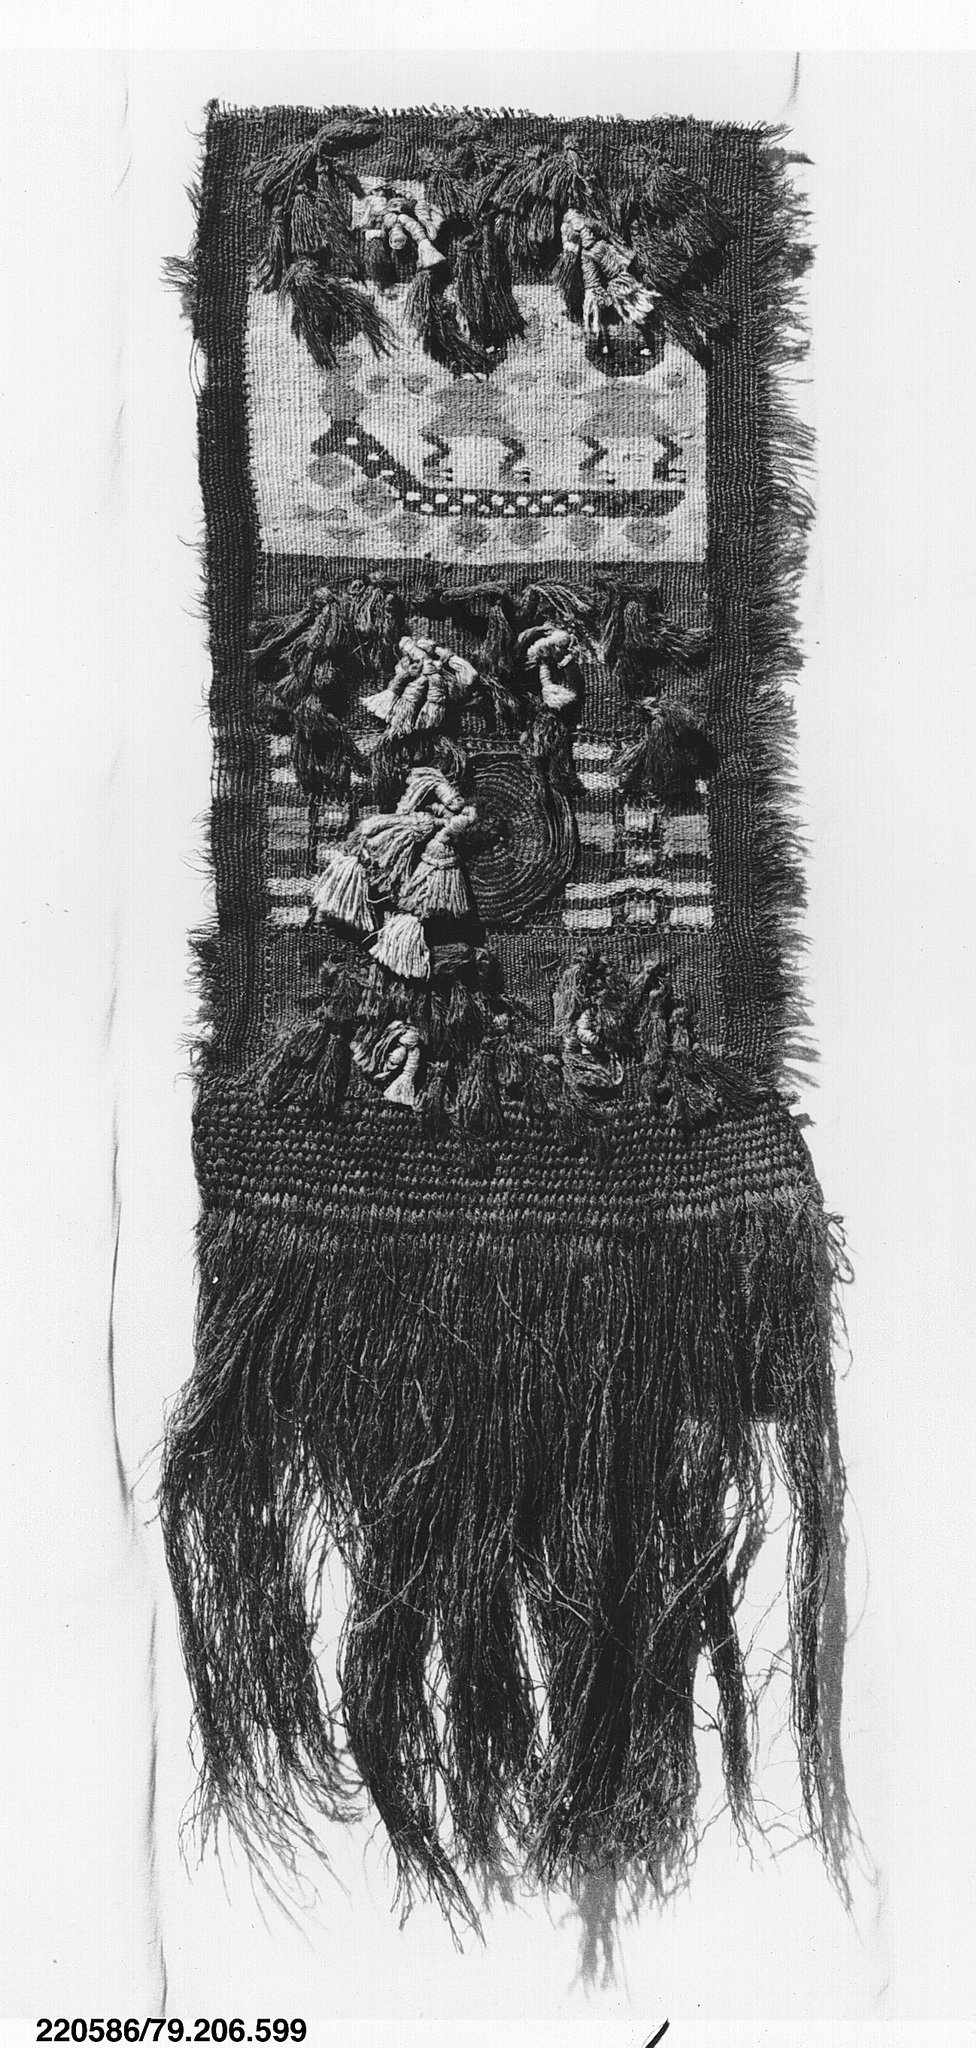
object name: turban fragment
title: Turban-end Panels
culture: chimú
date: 1101-1500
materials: animal fiber, cotton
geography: peru